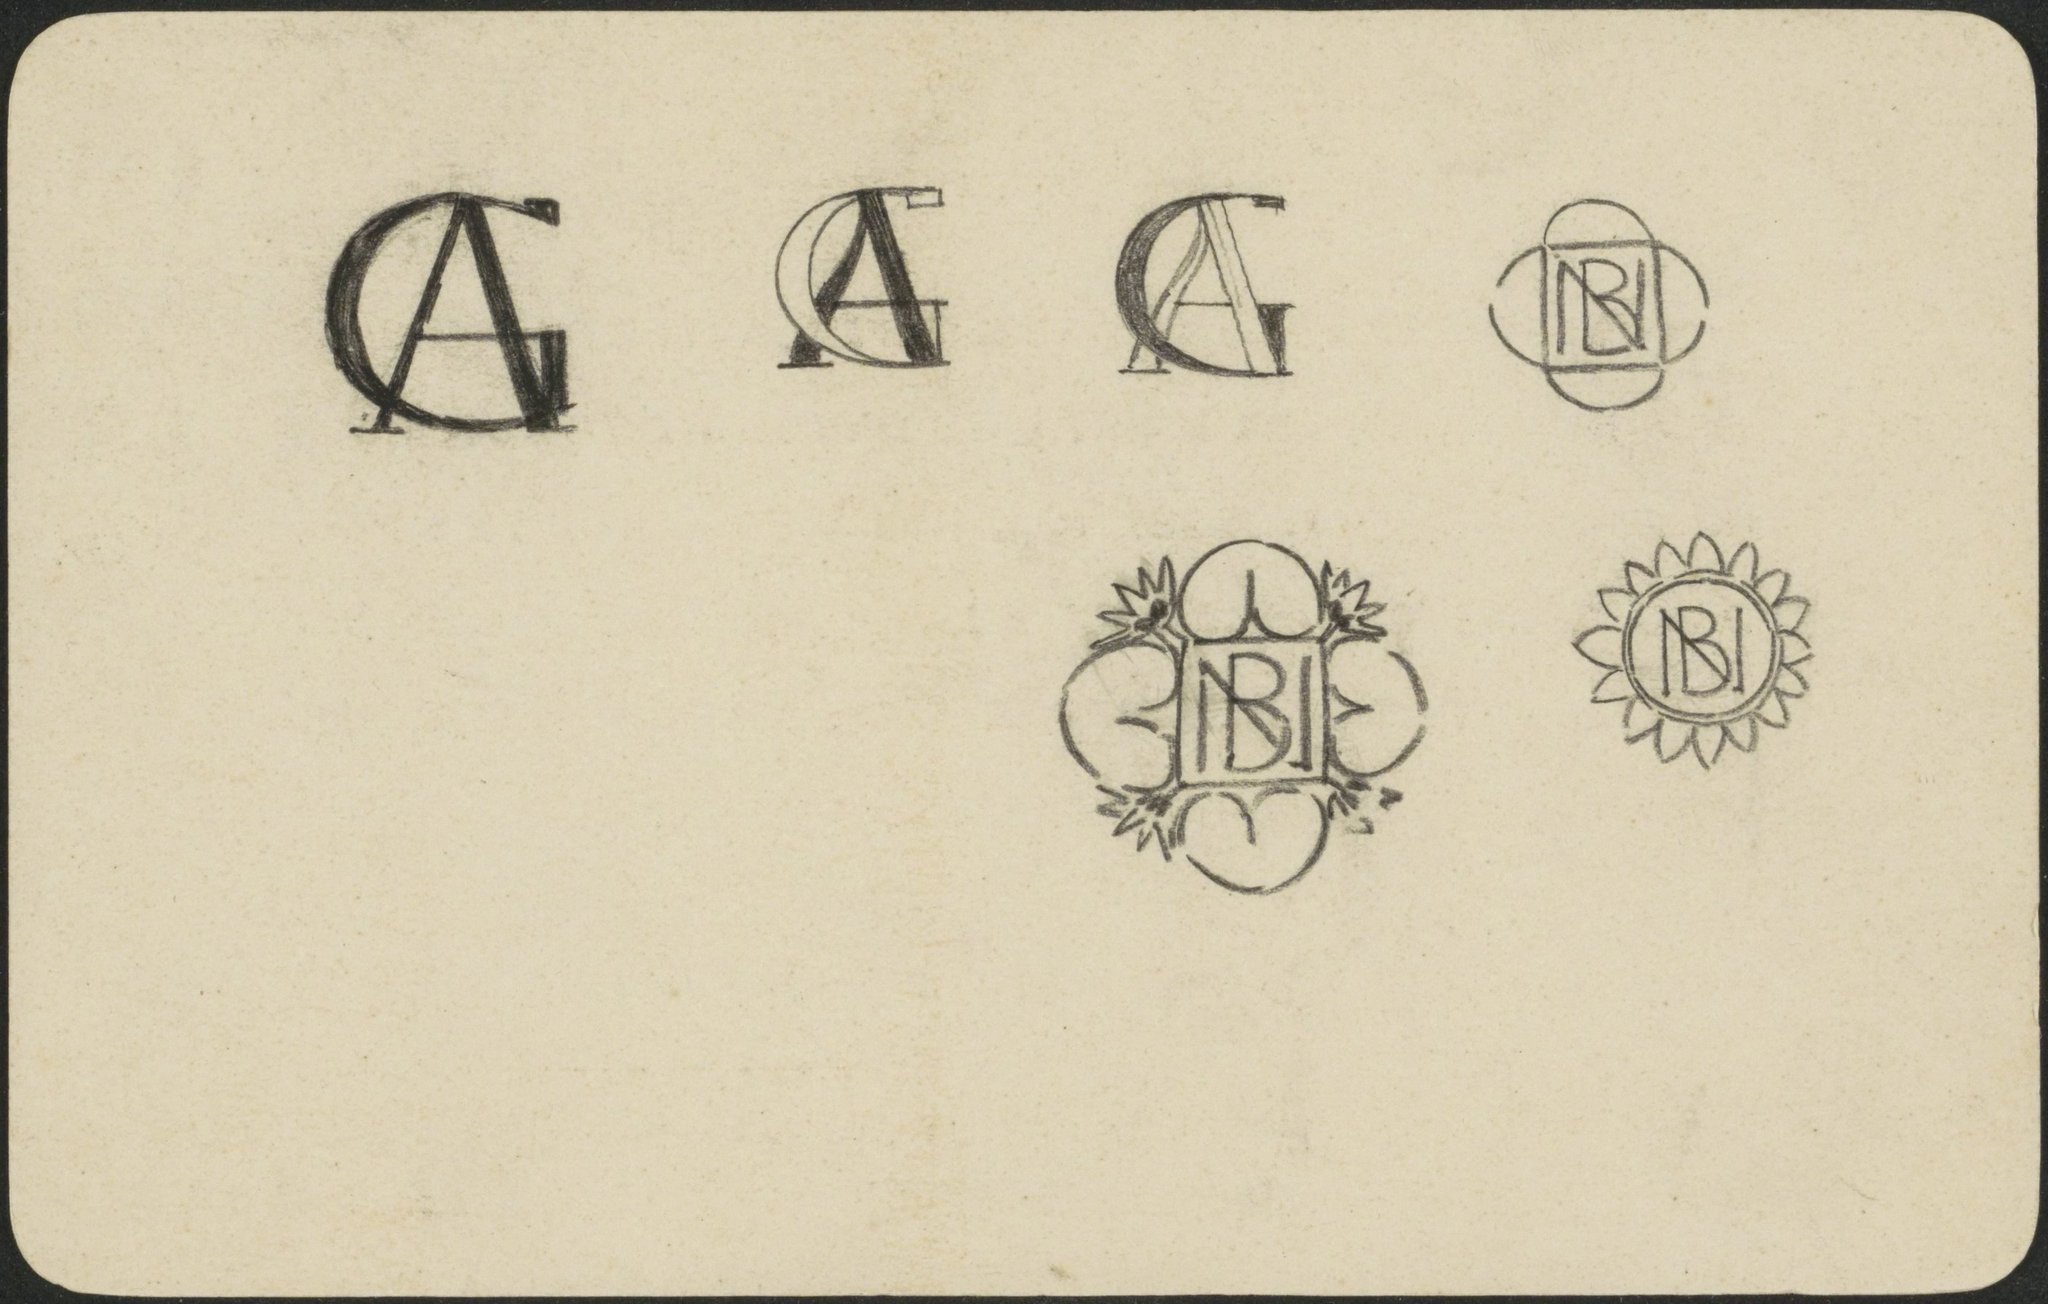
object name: drawing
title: Ontwerpen voor monogrammen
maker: gerrit willem dijsselhof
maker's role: designer, draughtsman, print maker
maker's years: 1866-1924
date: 1876-1924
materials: cardboard, chalk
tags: magic mathematical figures; magic numbers, words, monograms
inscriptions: annotation: ‘GA GA GA NB/ NB NB’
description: Tekening op verso van een uitnodiging voor een tentoonstelling van de vereniging Arti et Amicitiae.